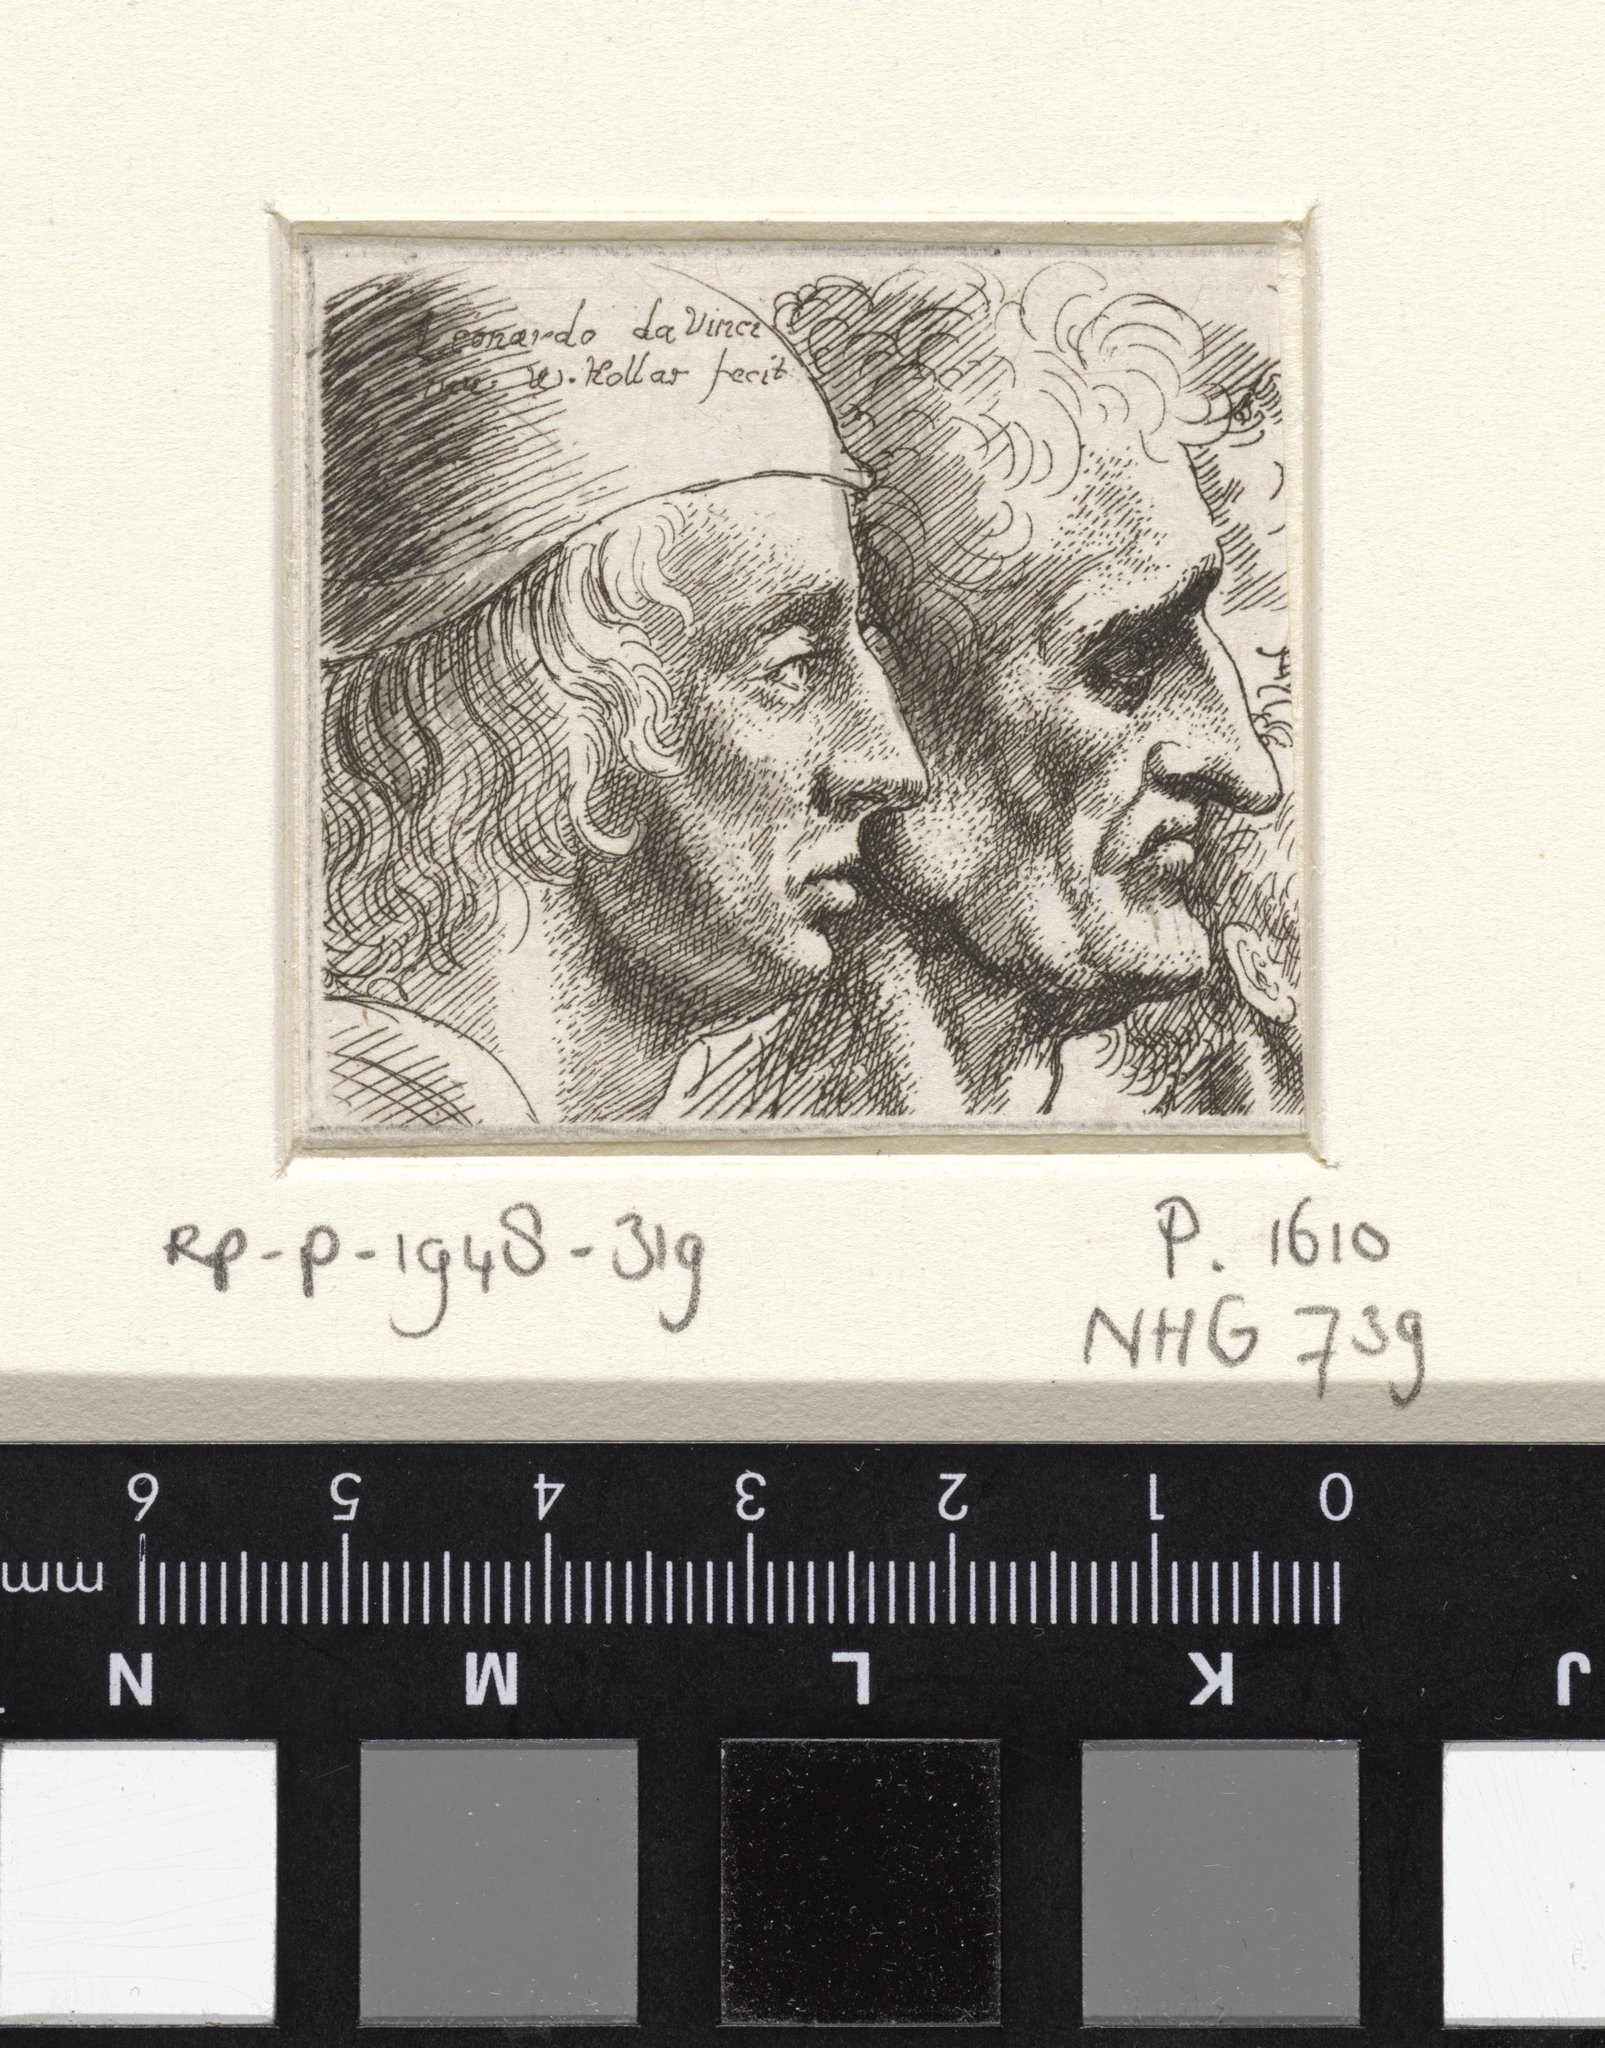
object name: print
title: Karikaturen, koppen en misvormingen naar Leonardo da Vinci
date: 1645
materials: paper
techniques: etching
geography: antwerp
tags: head (human)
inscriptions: collector's mark: Lugt 2228